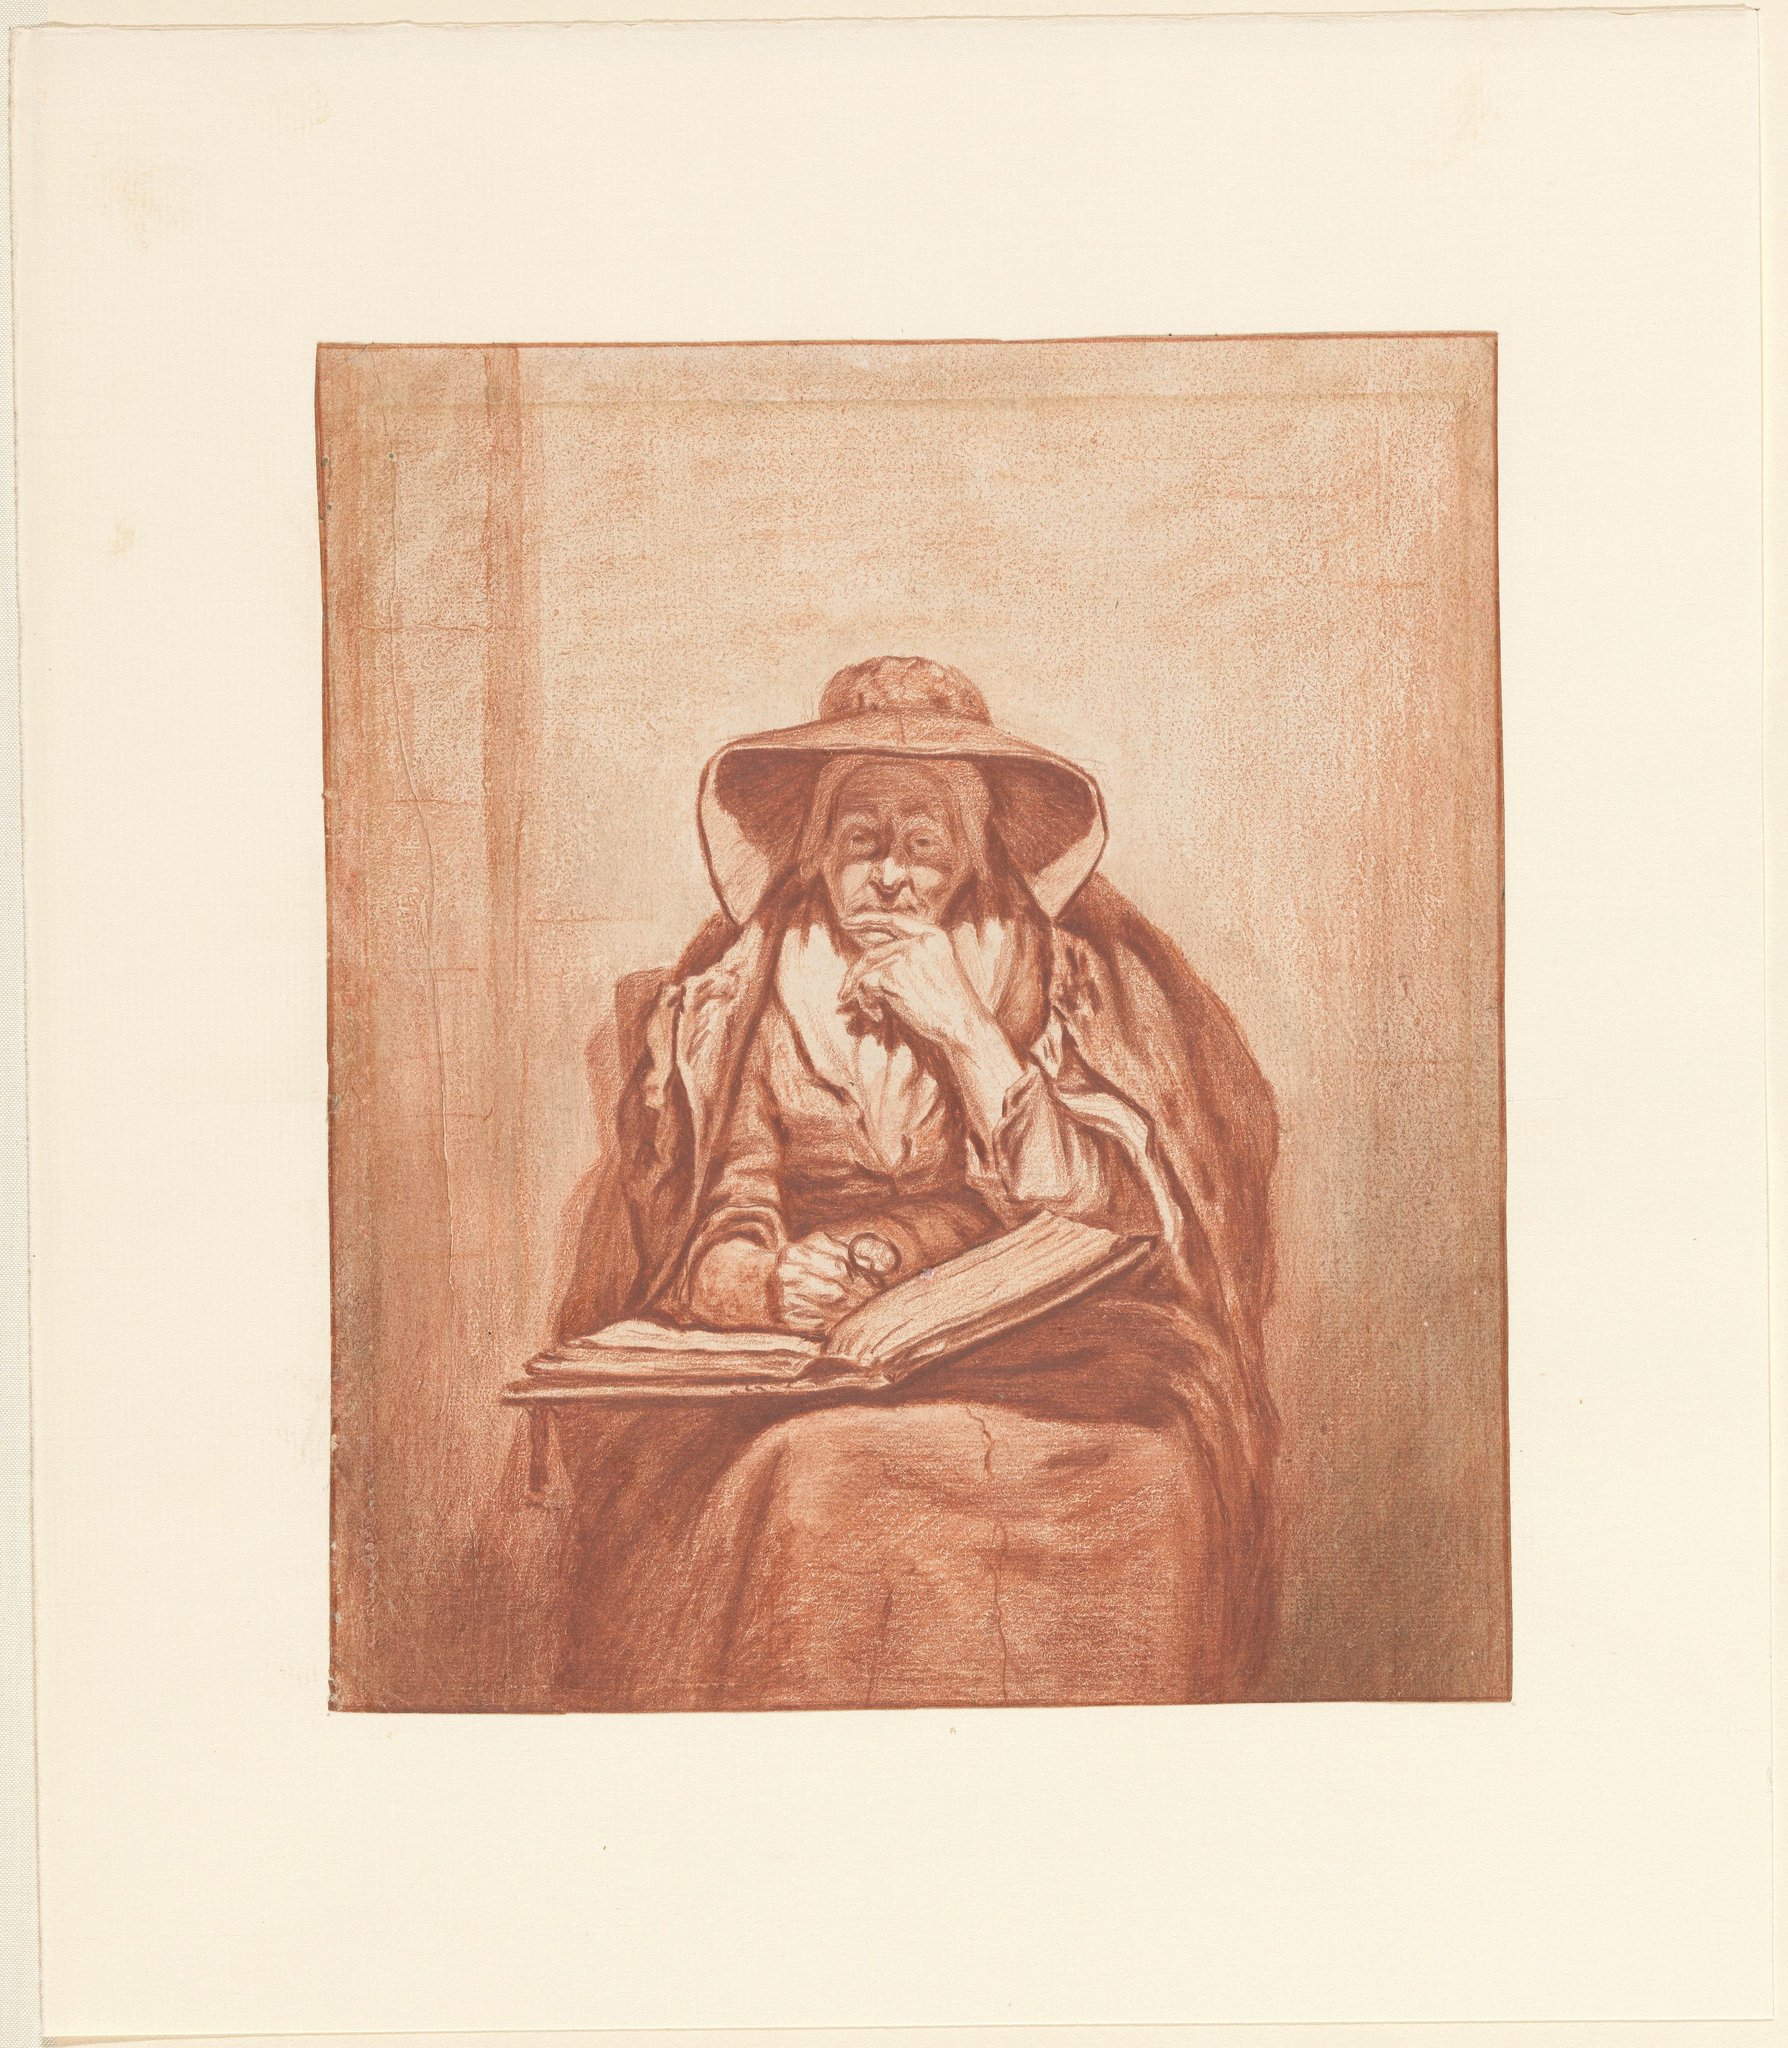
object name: drawing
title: Peinzende oude vrouw, met een boek op haar schoot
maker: pieter christoffel wonder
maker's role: draughtsman, painter, print maker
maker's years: 1780-1852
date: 1790-1852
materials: chalk, paper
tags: sitting figure - aa - female human figure, book - mm - book open